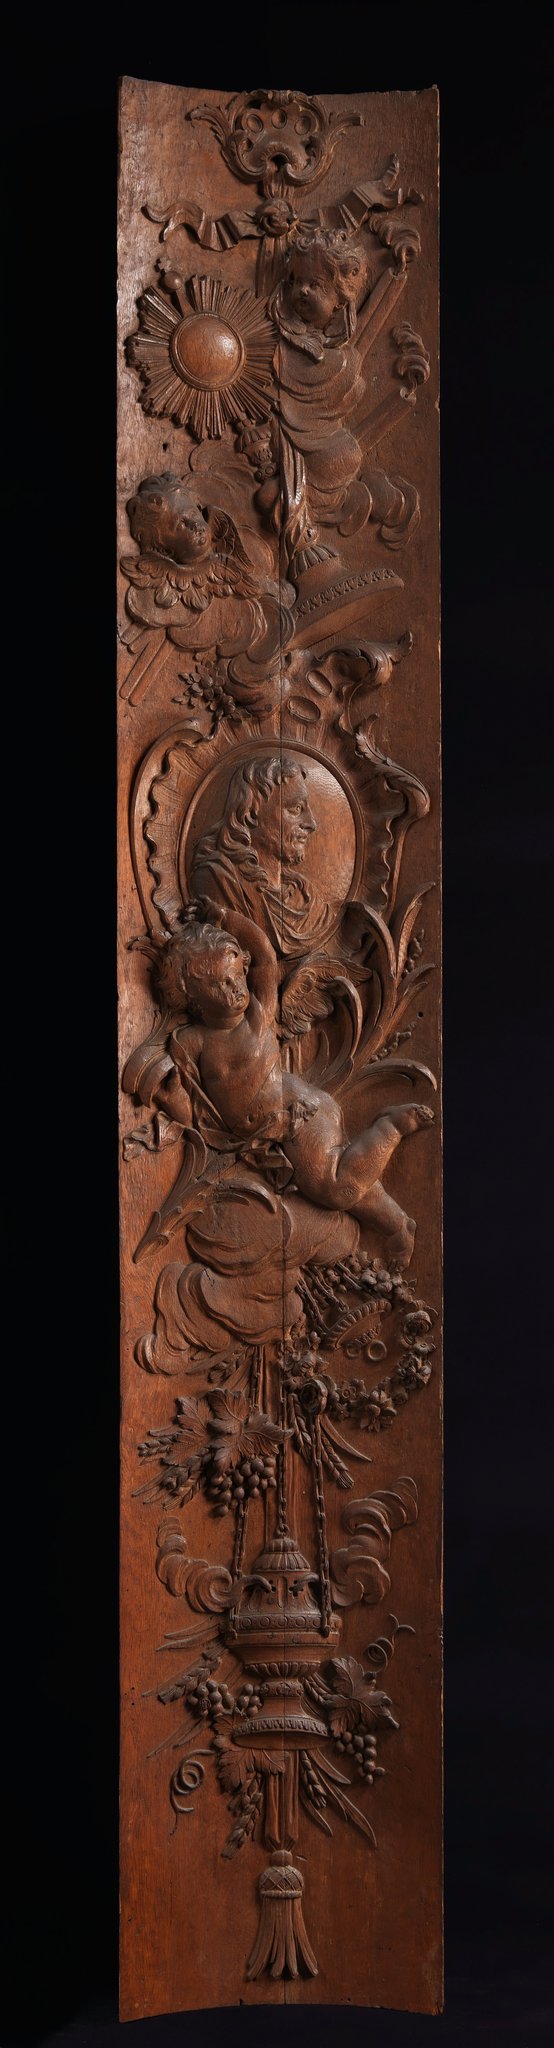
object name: panel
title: Panel (one of a pair)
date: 1725-1735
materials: wood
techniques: carving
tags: men,profiles,angels